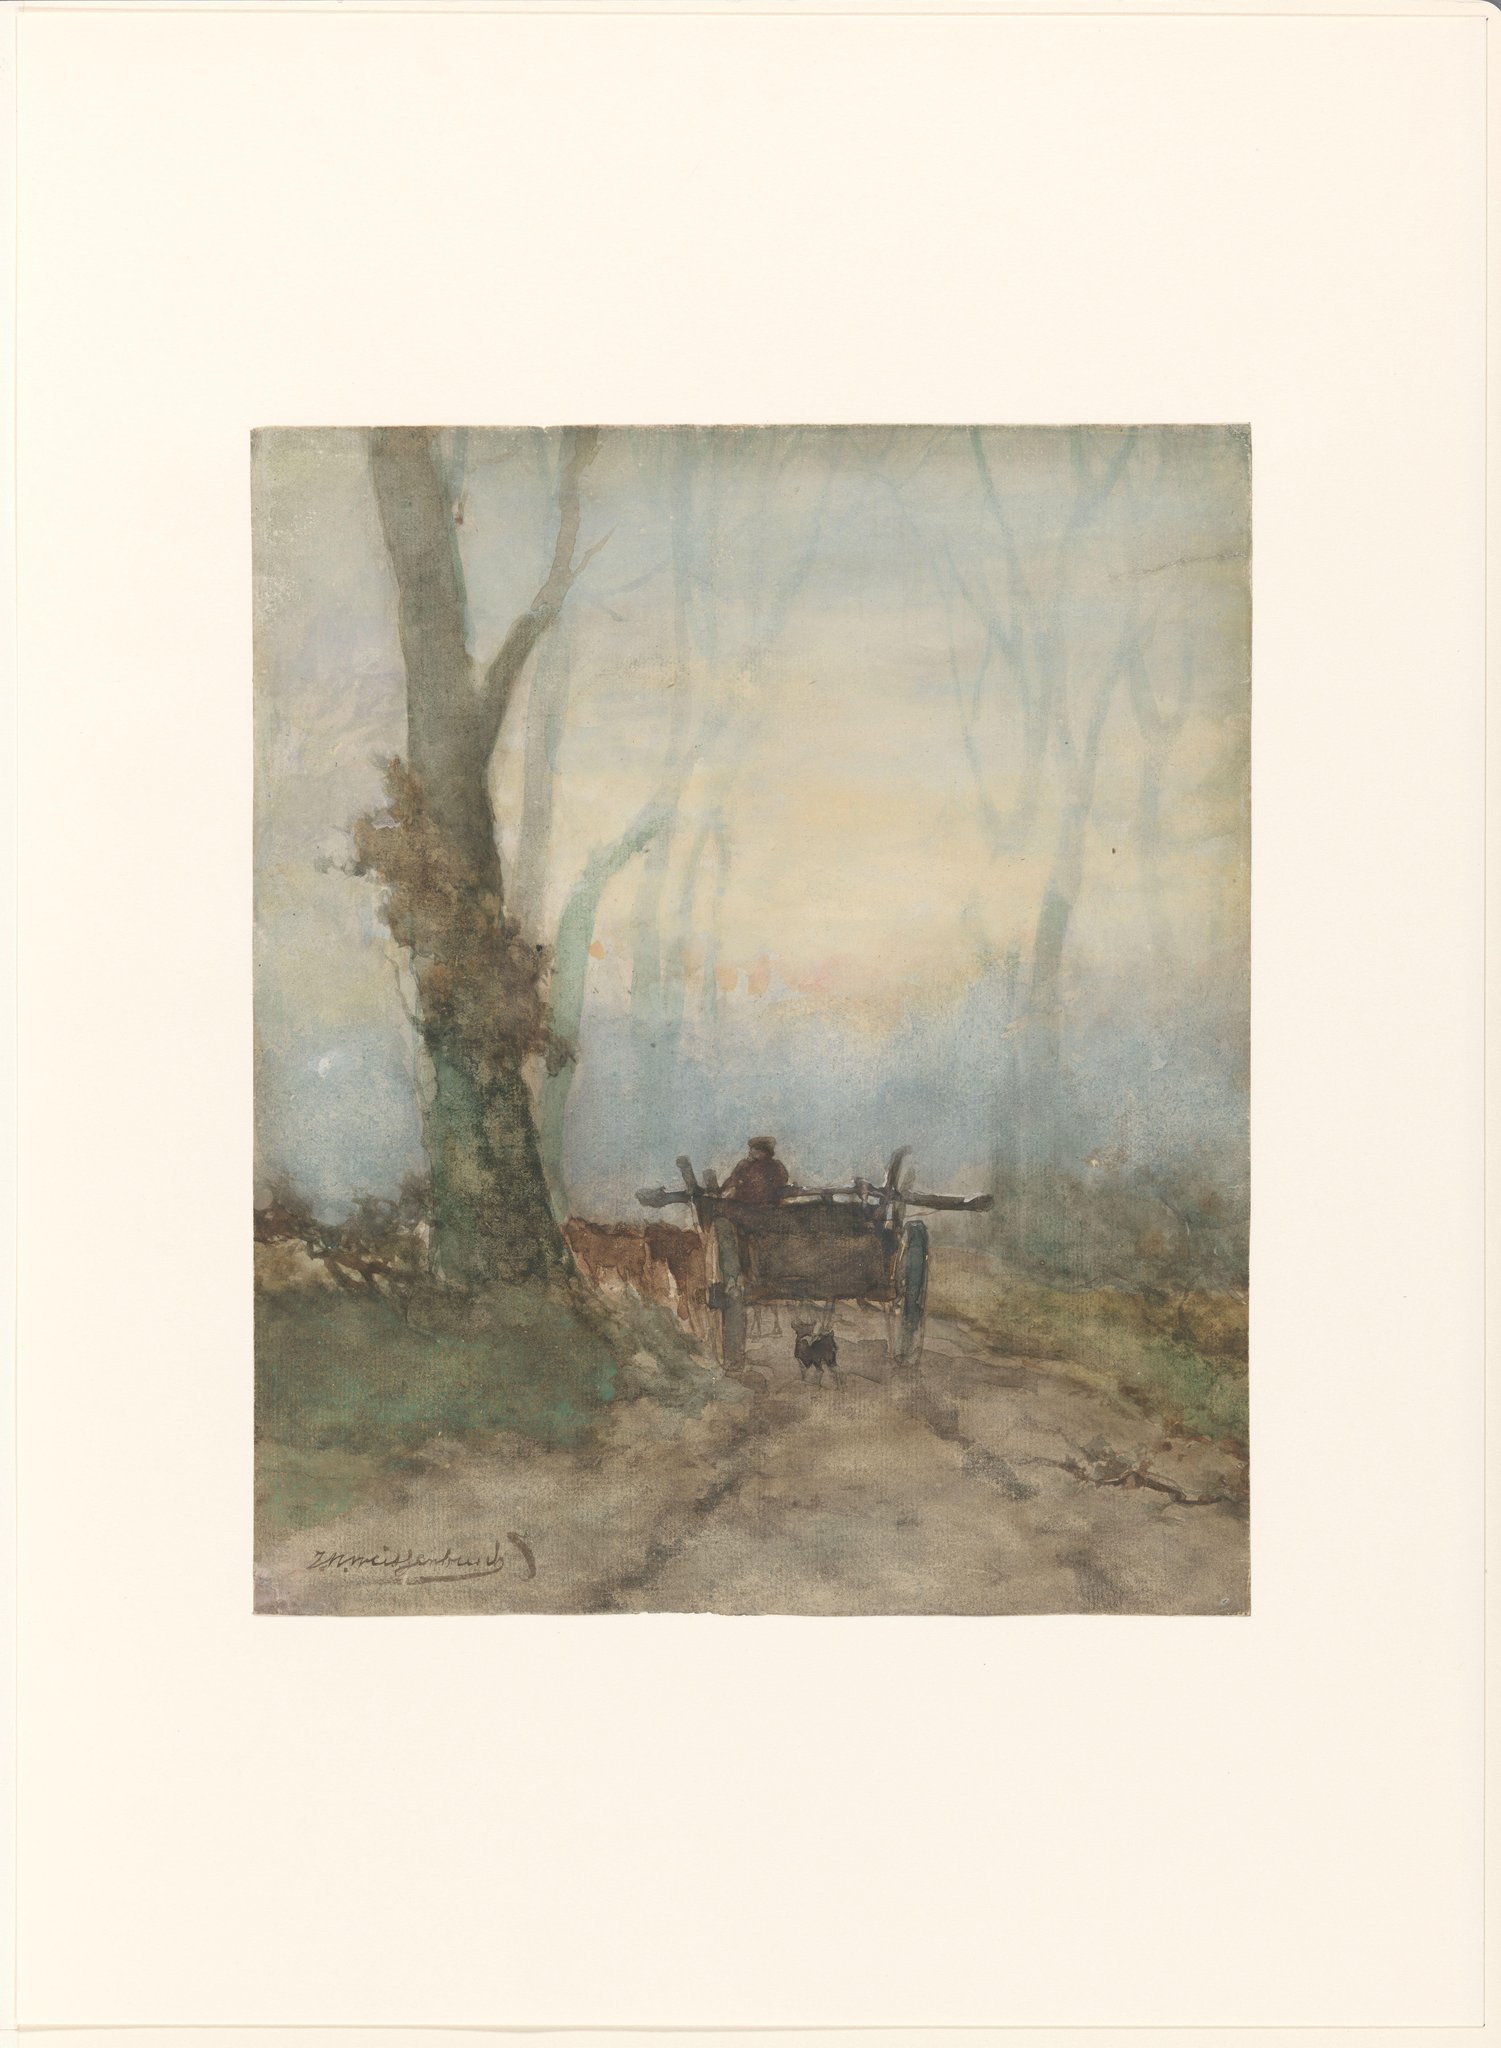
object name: watercolor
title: Boerenkar op bosweg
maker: johan hendrik weissenbruch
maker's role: draughtsman, painter, print maker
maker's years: 1824-1903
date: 1834-1903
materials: paper, watercolor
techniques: brush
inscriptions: collector's mark: Lugt 2288